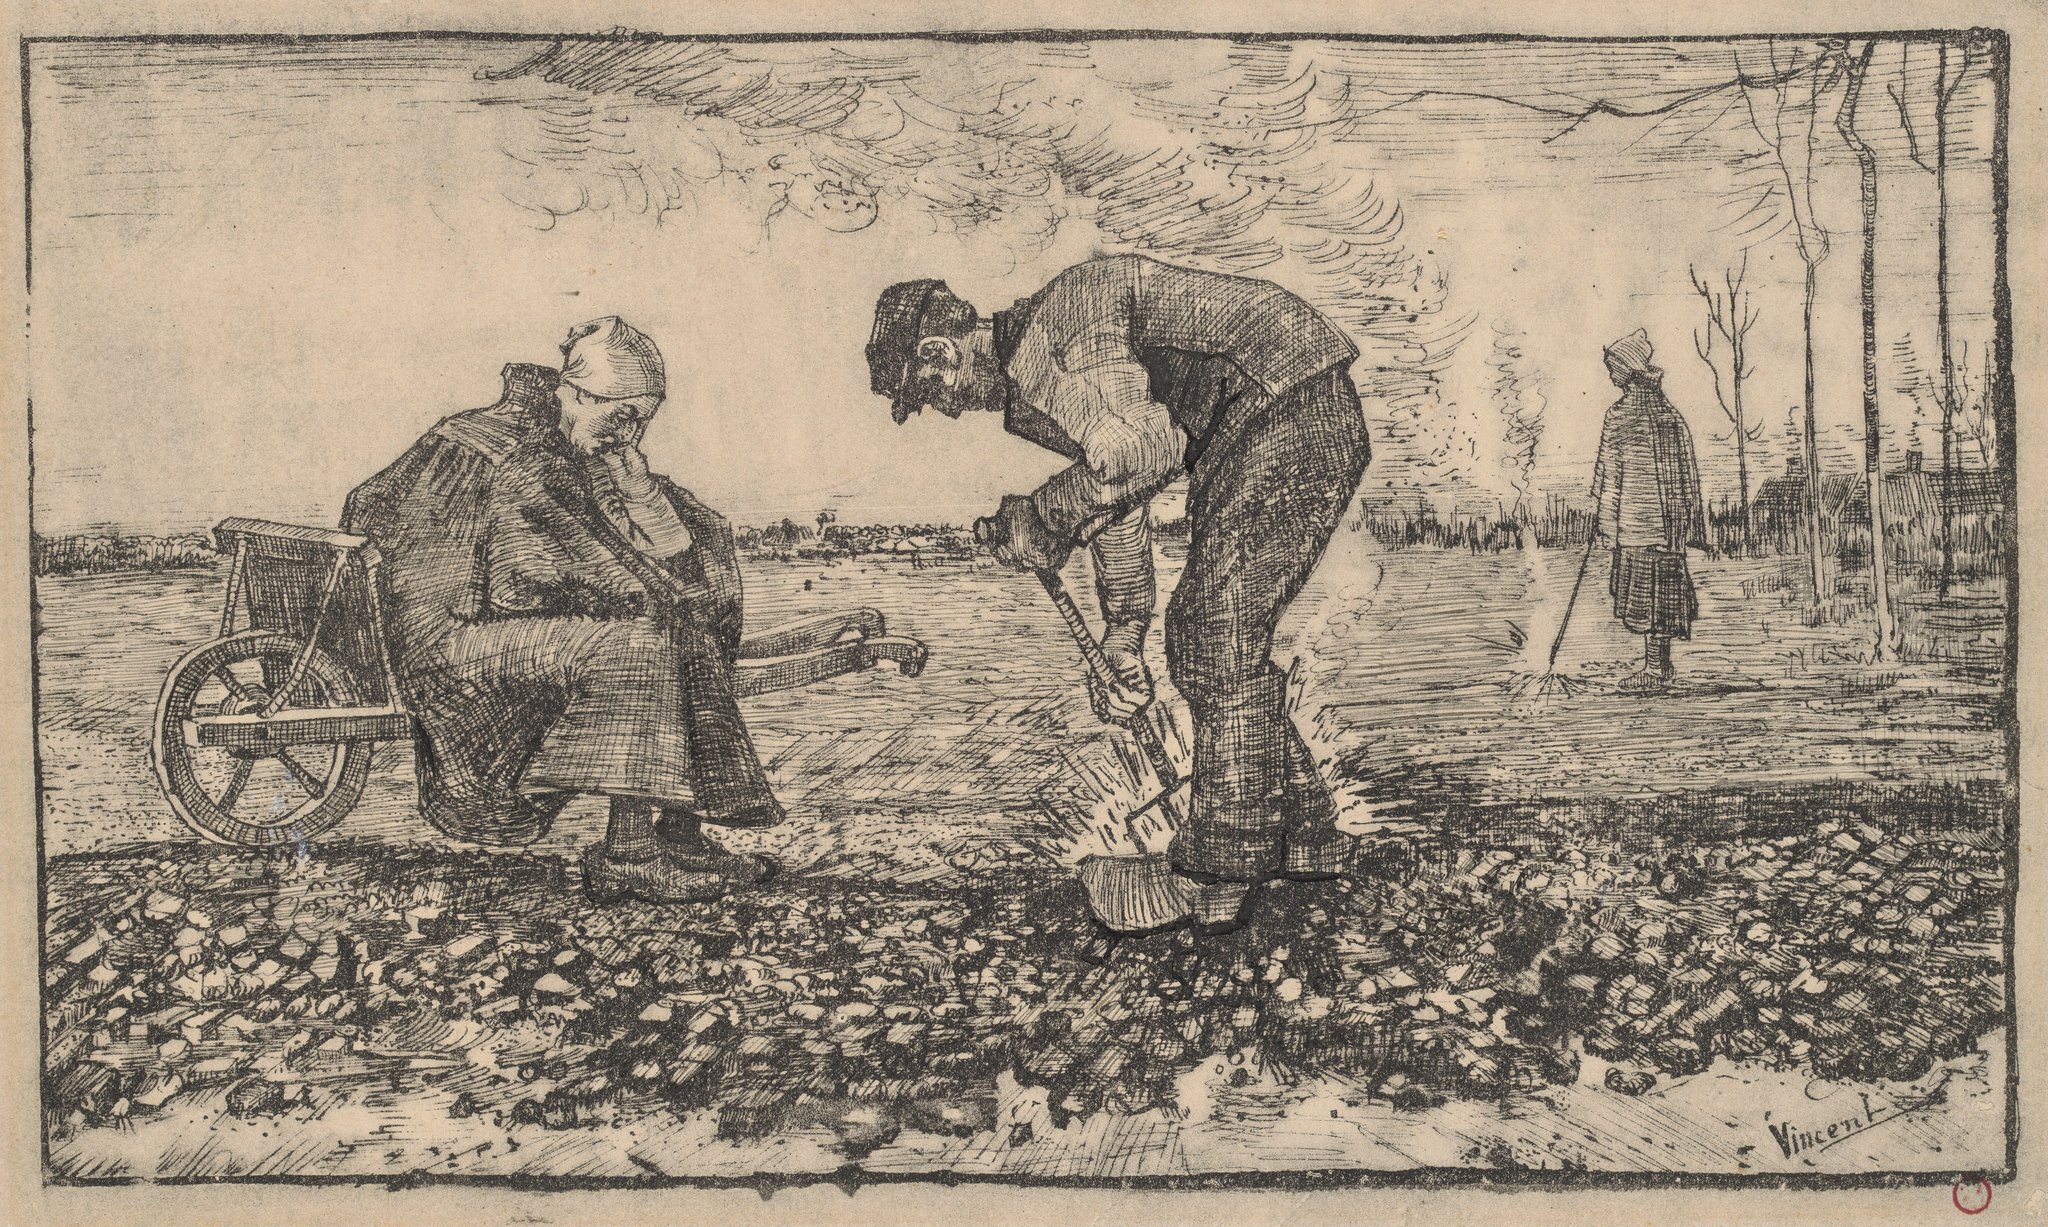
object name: print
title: Burning Weeds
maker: vincent van gogh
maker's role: artist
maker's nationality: dutch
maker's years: 1853-1890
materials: ink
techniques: pen, lithography